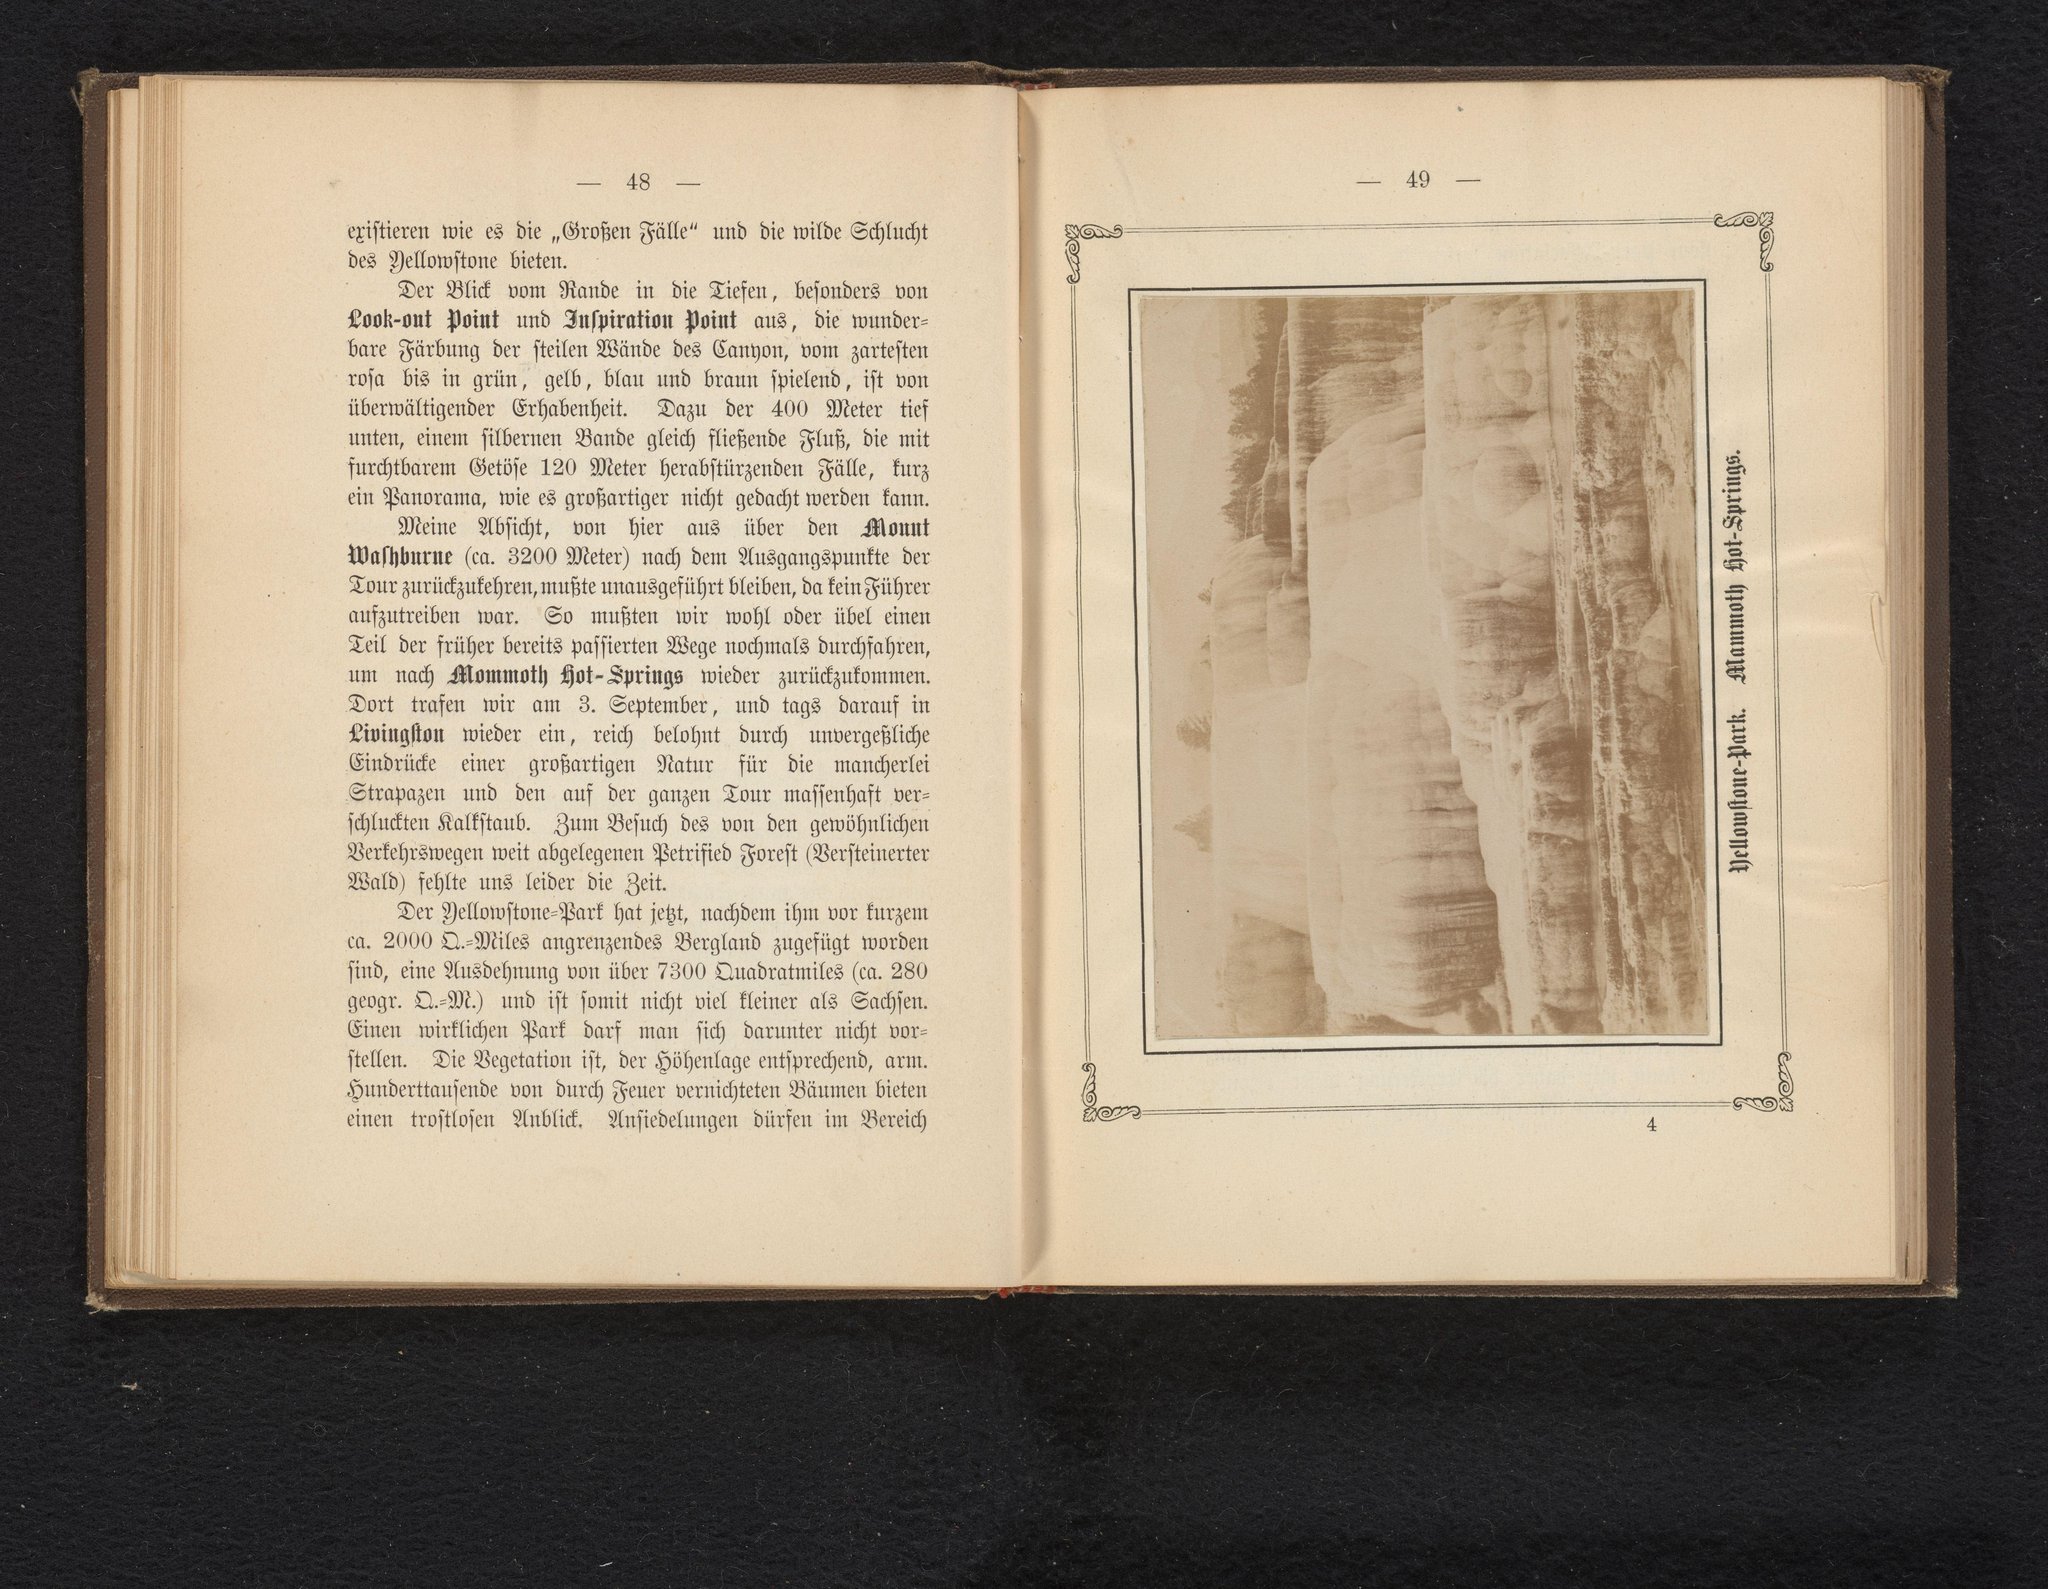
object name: photograph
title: Yellowstone-Park, Mammoth Hot-Springs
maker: Anonymous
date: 1889-1894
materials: paper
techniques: albumen print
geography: yellowstone national park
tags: hot spring, geyser